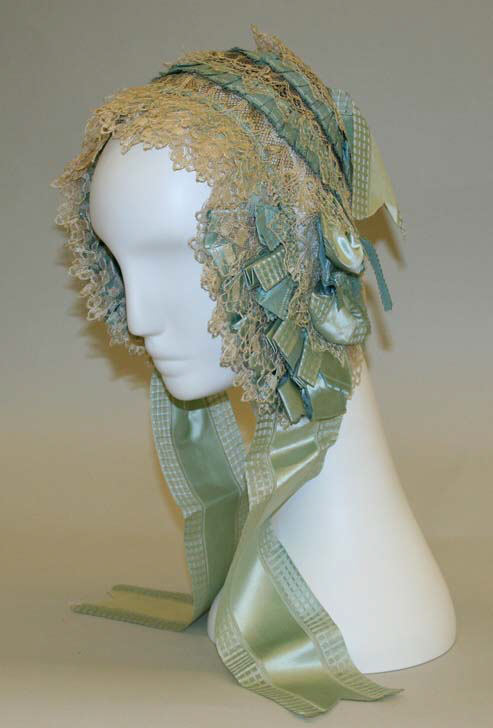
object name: cap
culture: american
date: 1845-1850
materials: silk